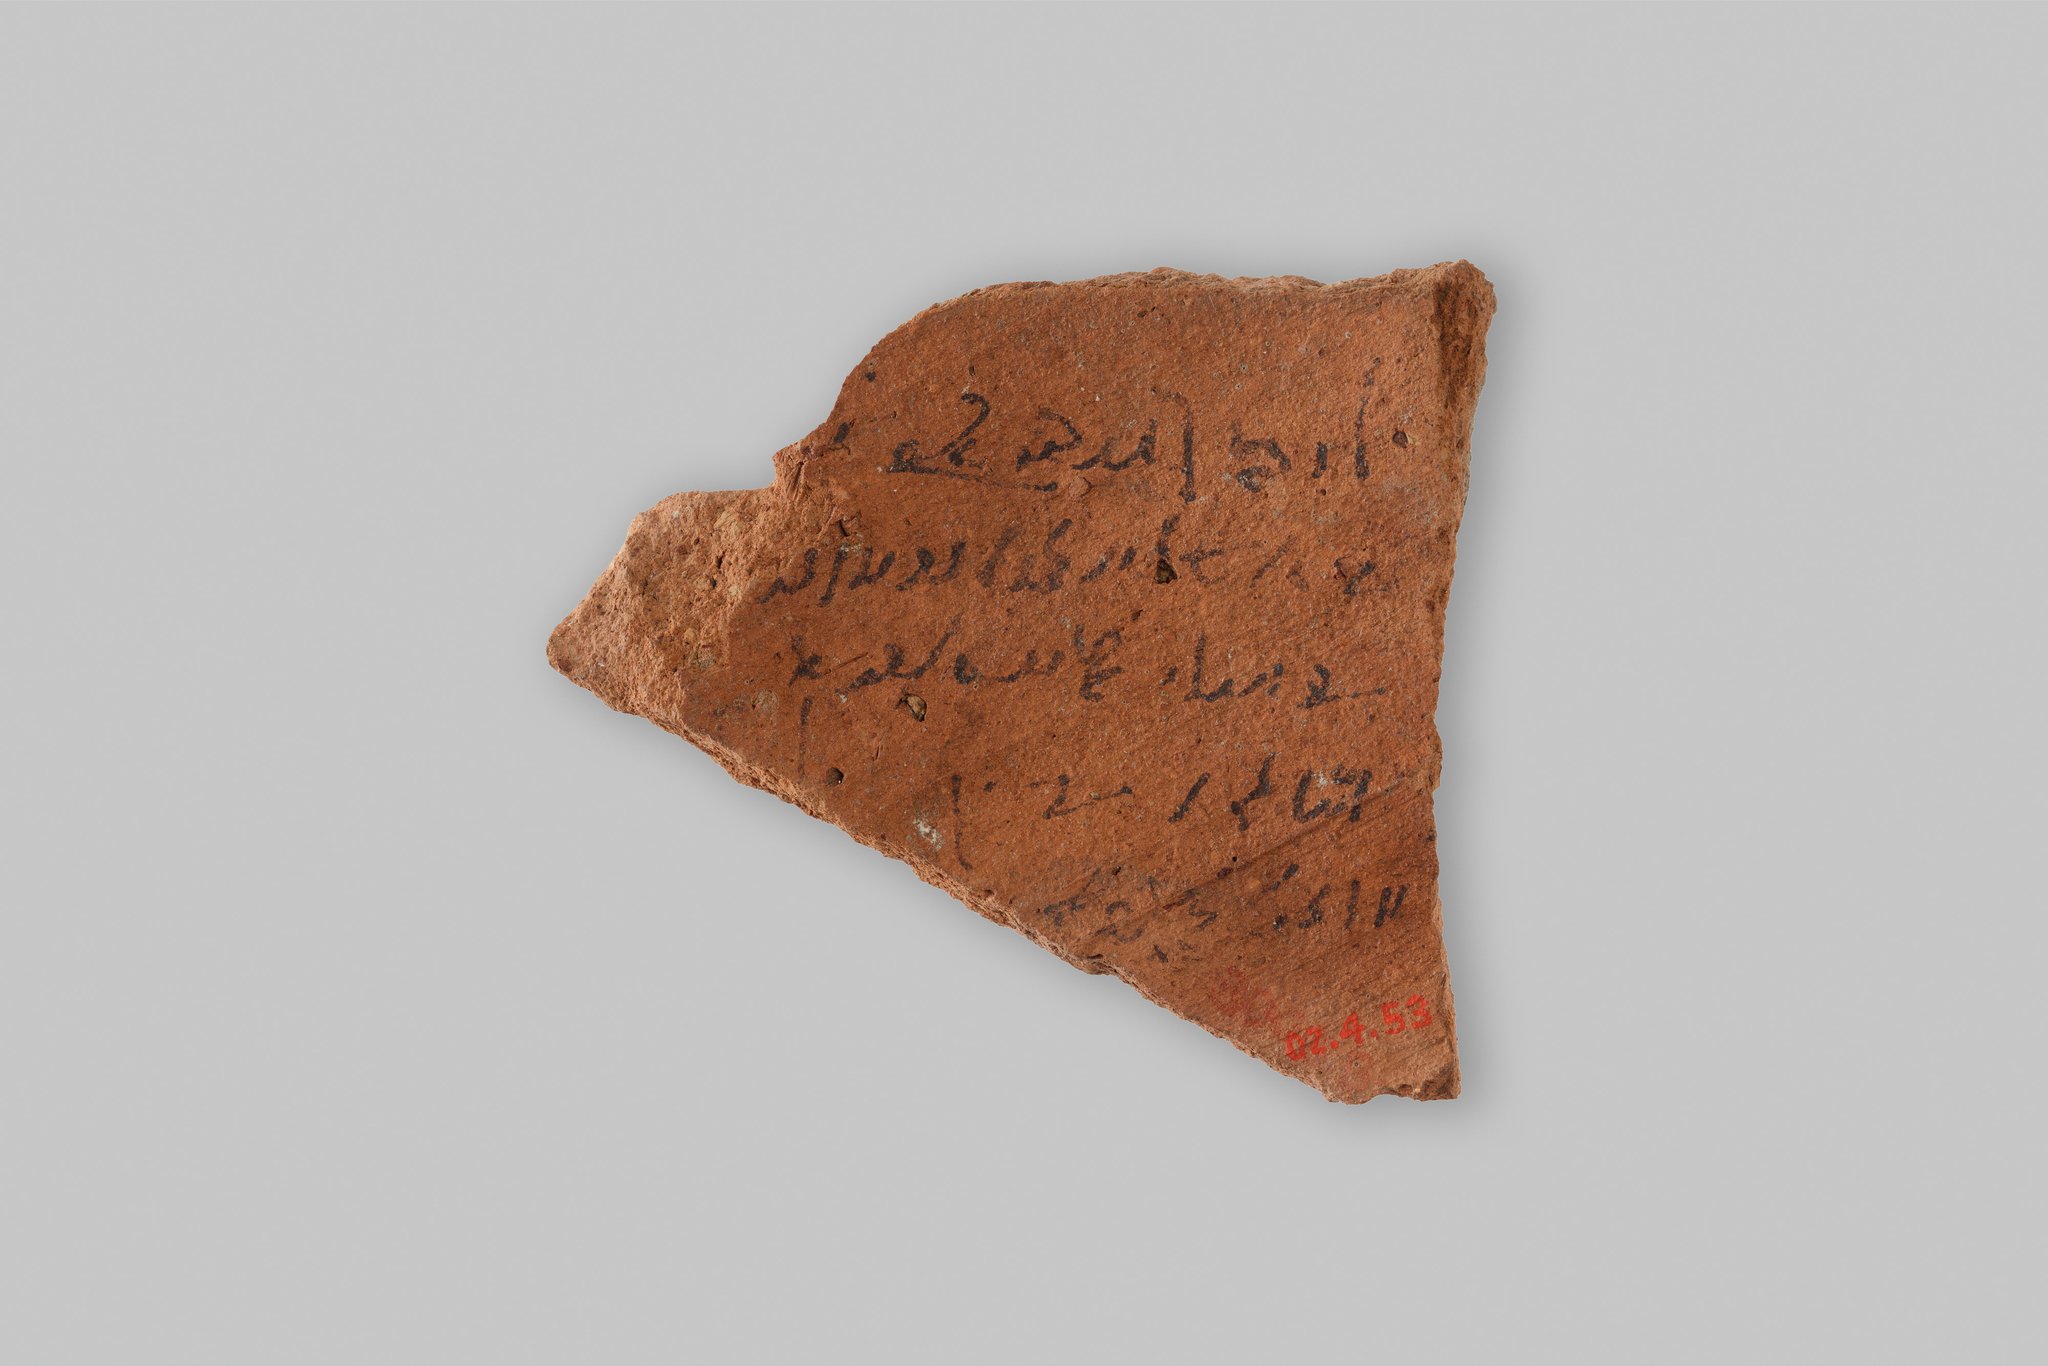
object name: ostracon, demotic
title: Ostracon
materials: ink, pottery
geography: egypt